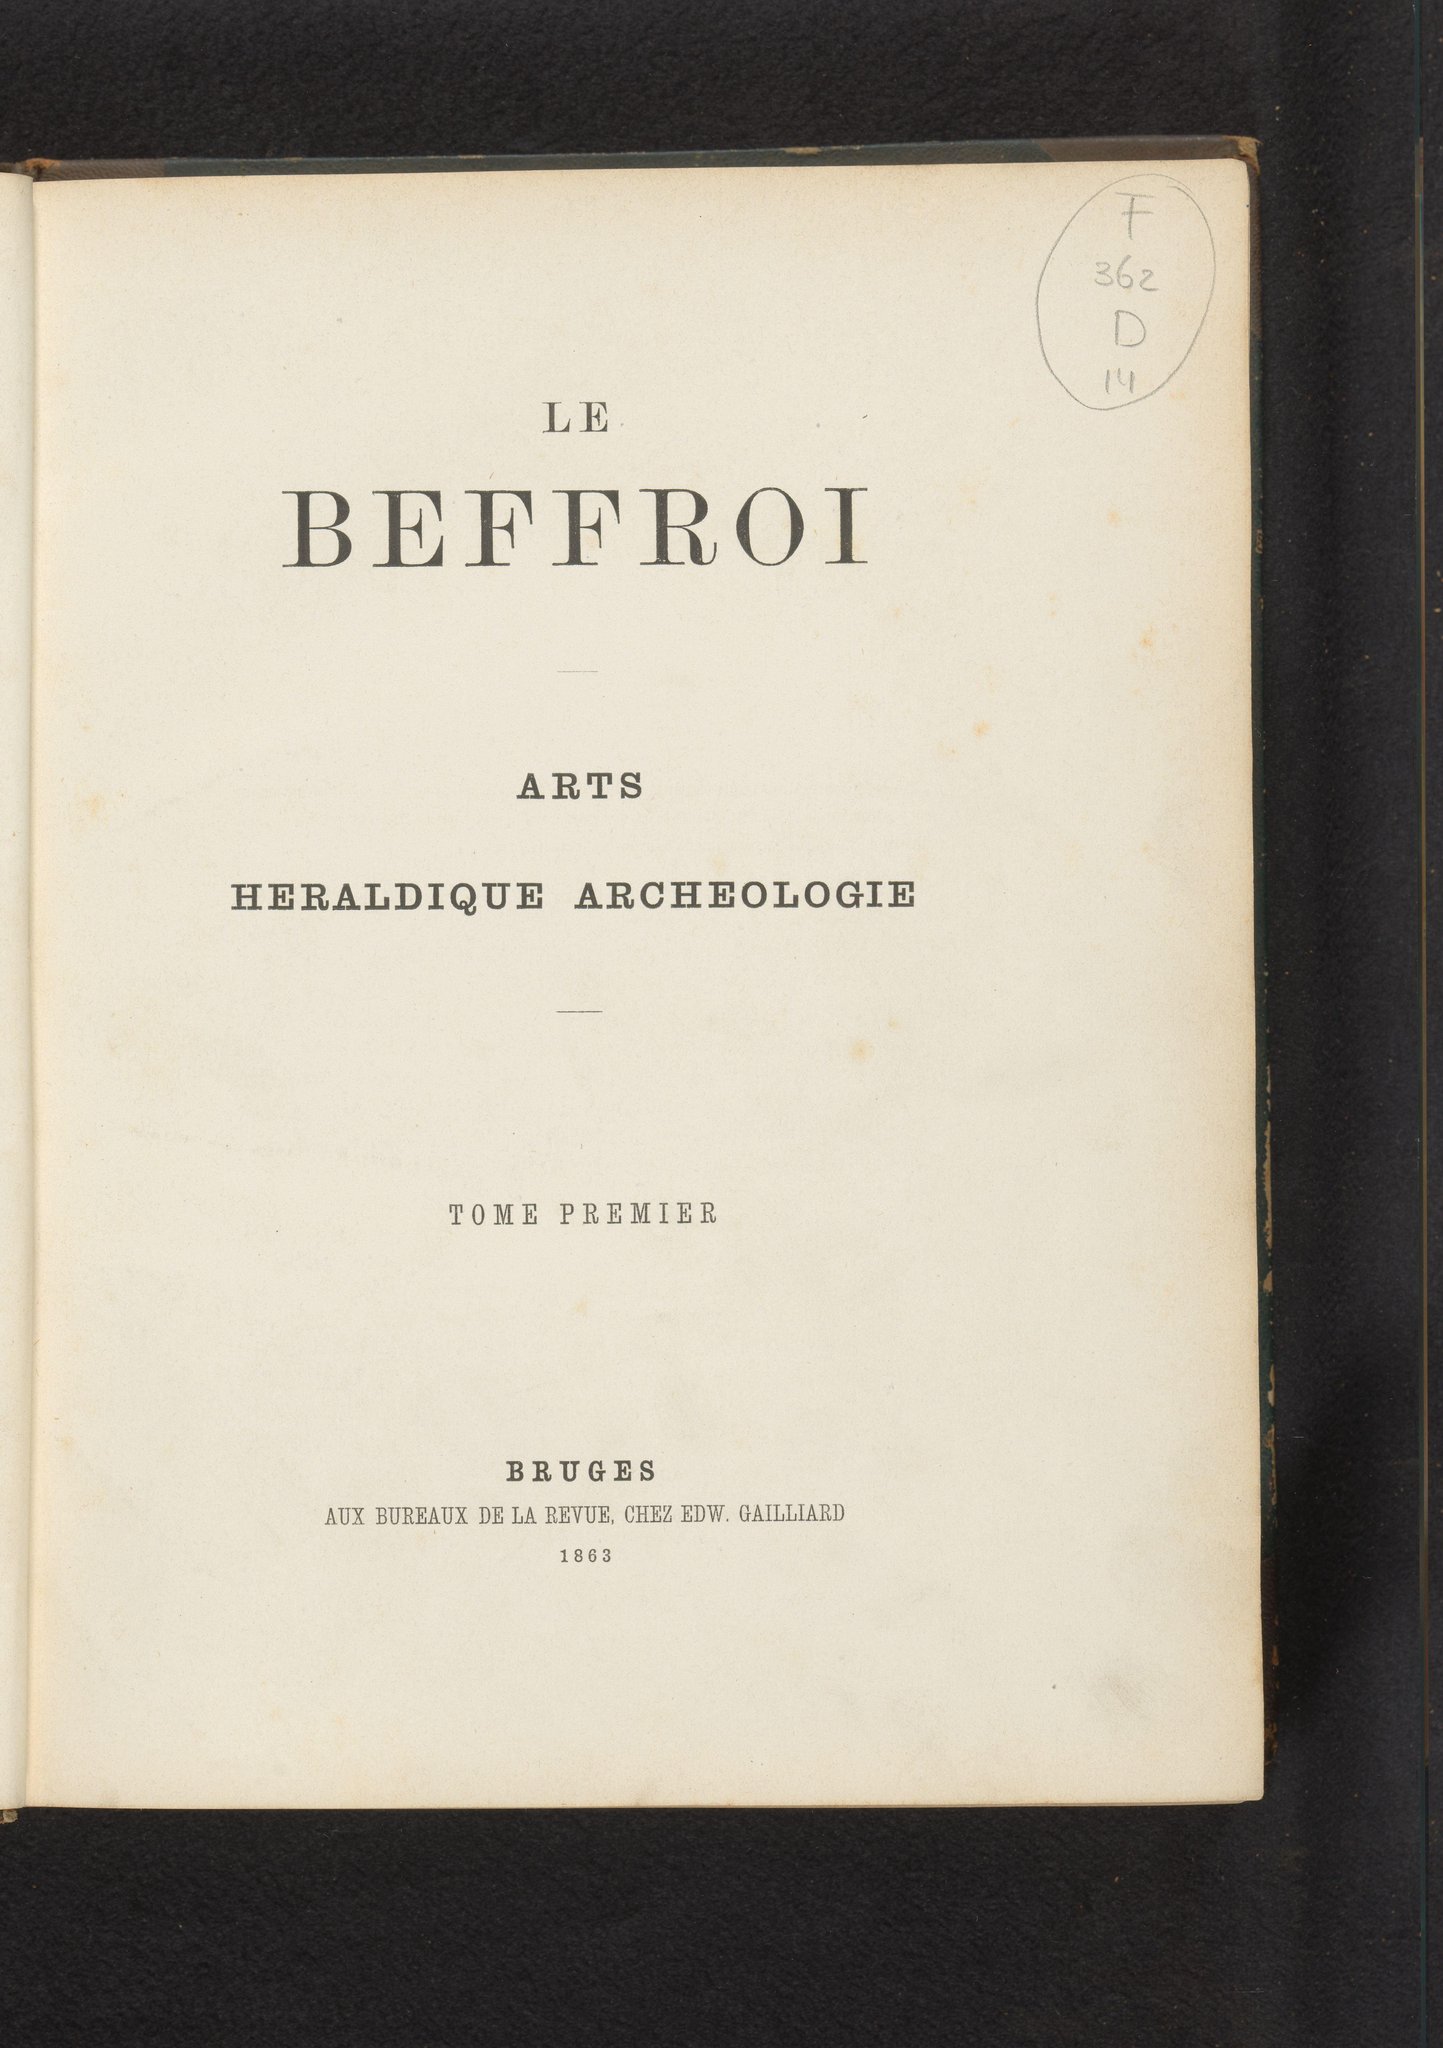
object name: book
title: Le beffroi : arts, héraldique, archéologie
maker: edward gailliard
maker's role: publisher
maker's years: 1841-1922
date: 1863-1865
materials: cardboard, leather, linen, paper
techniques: photolithography, printing, marbling, engraving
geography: bruges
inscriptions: date: ‘JAN/ 1992’